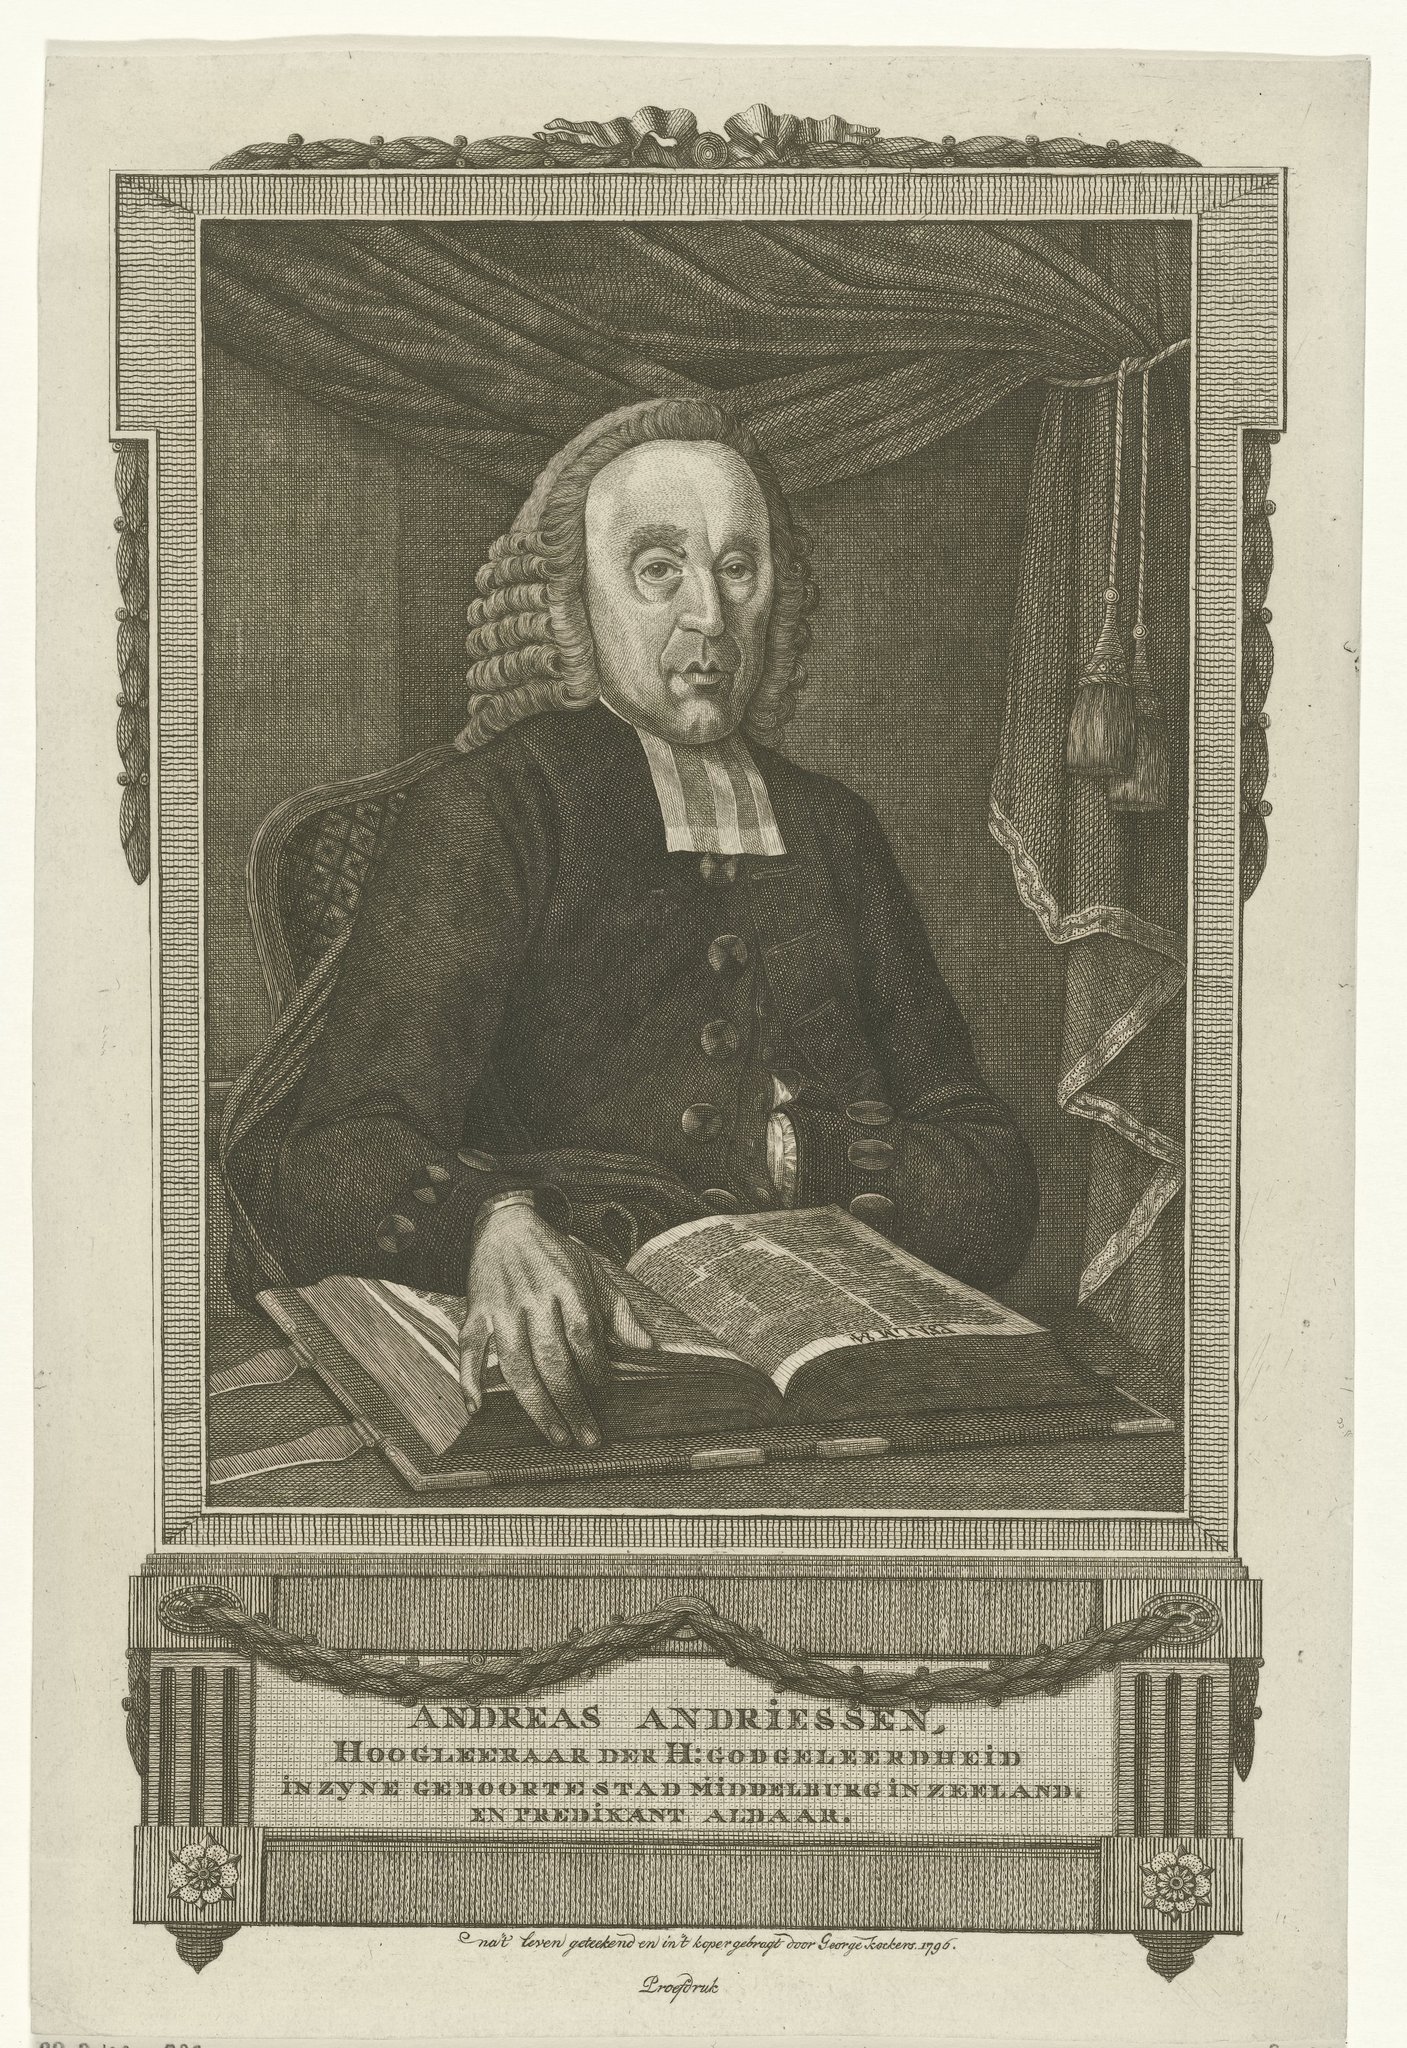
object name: print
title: Portret van Andreas Andriessen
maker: george kockers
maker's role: goldsmith, print maker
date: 1796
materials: paper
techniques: engraving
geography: middelburg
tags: middelburg, bible, wig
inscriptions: collector's mark: Lugt 2228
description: Portret ten halven lijven van Andreas Andriessen, predikant en hoogleraar te Middelburg. Andriessen, zit achter een tafel en draagt een batterijpruik en een bef. Zijn linkerhand heeft hij in zijn jas gestoken terwijl hij met zijn rechterhand door de bijbel bladert. Onder de afbeelding een vierregelig onderschrift met zijn naam en titels.